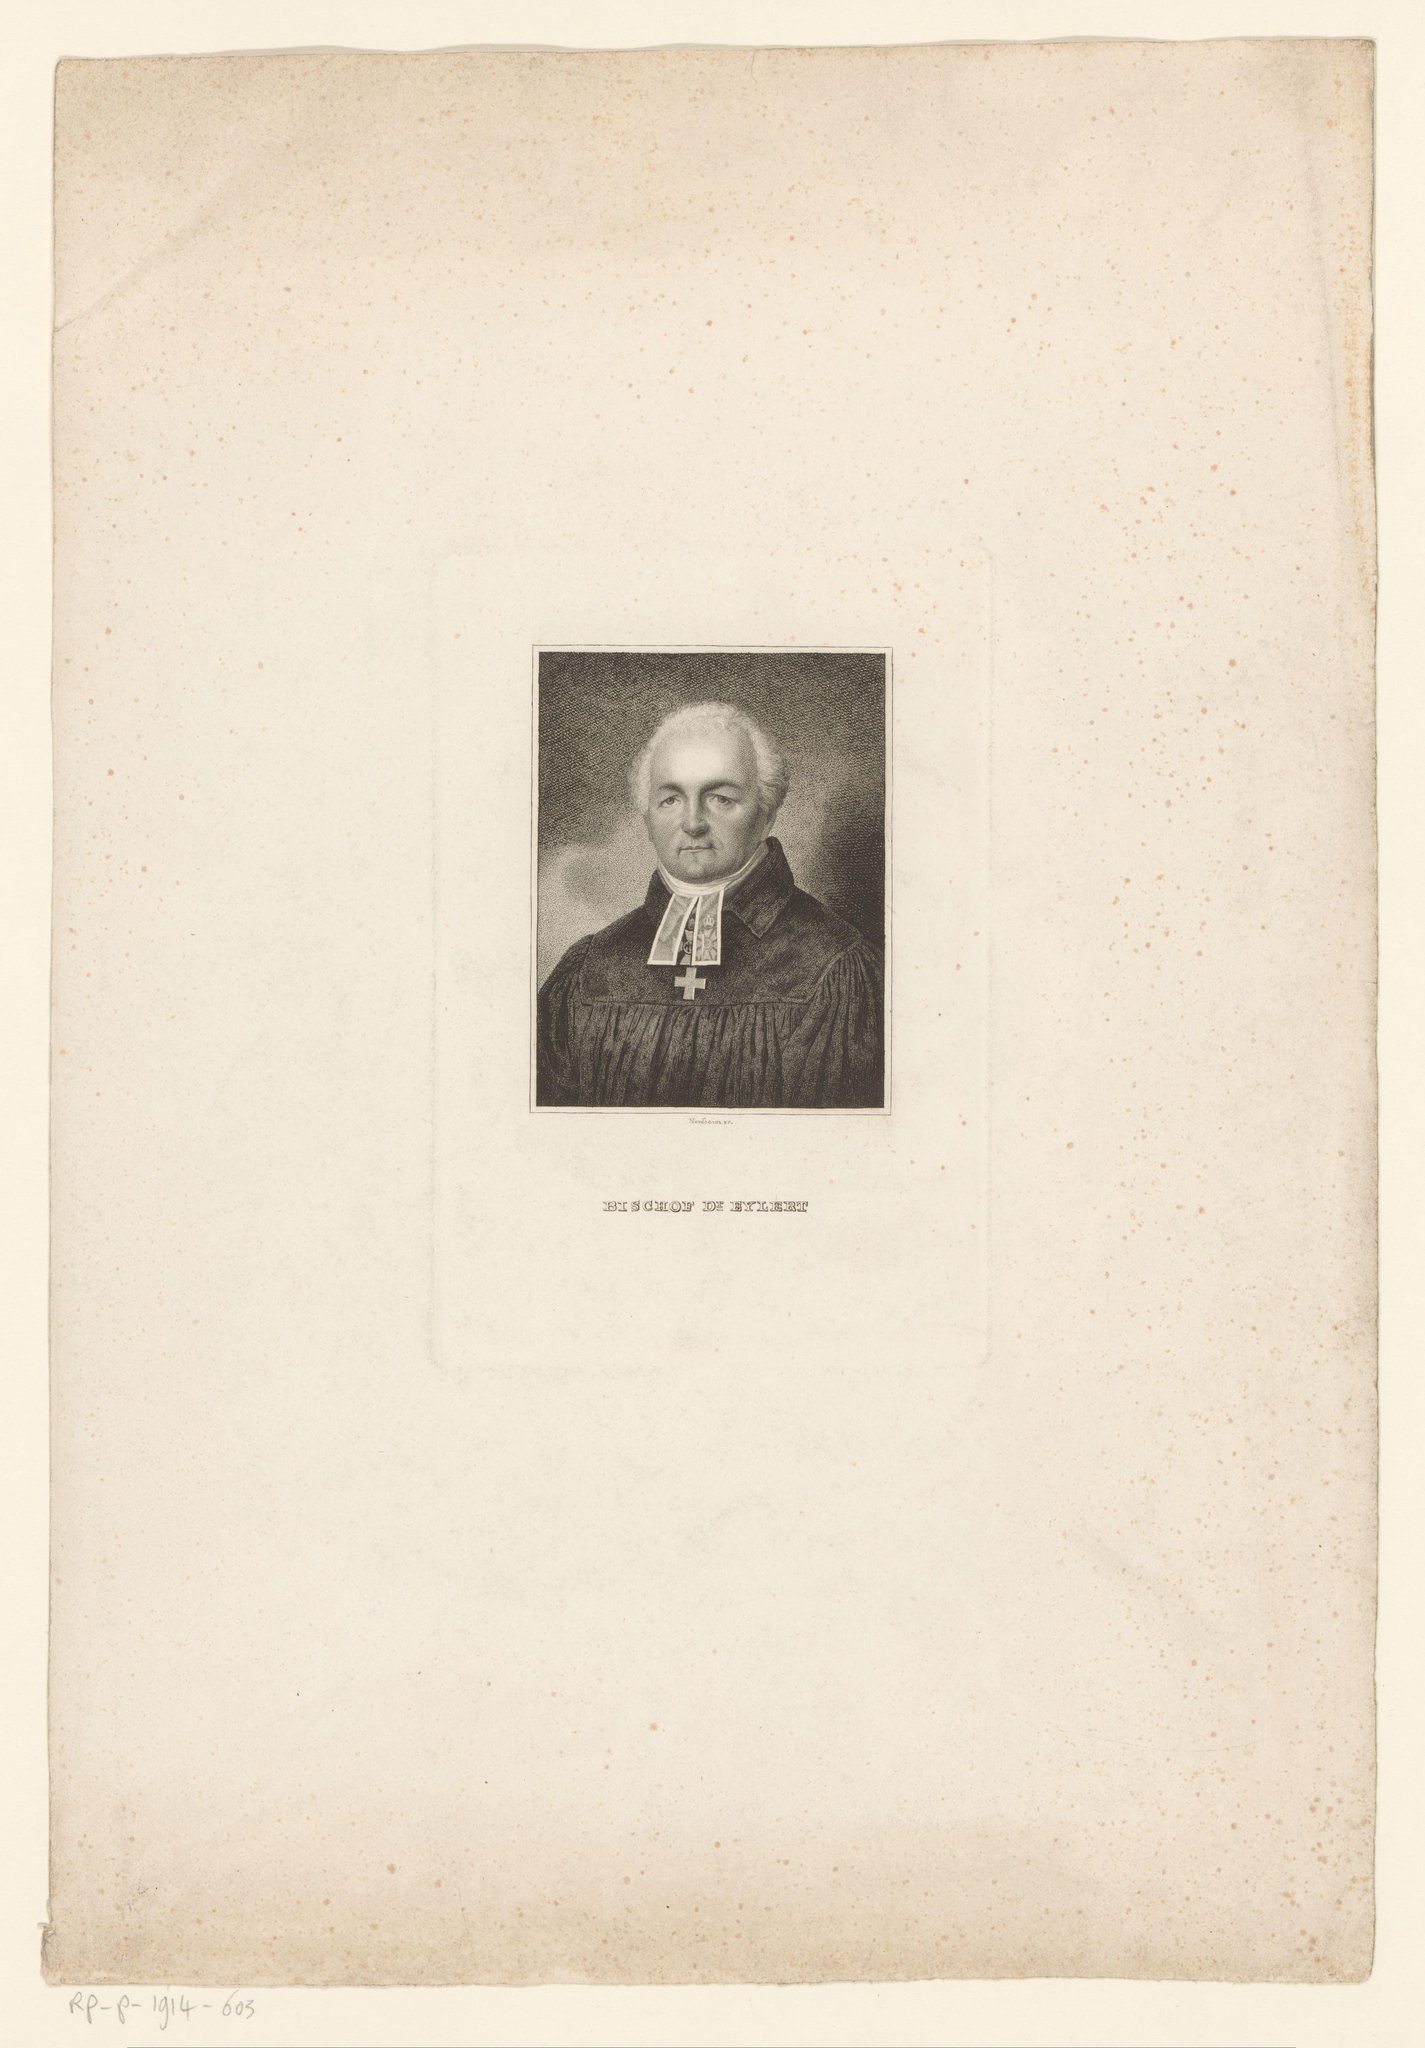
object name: print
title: Portret van Rulemann Friedrich Eylert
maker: johann georg nordheim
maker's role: print maker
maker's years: 1804-1853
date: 1814-1829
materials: paper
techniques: engraving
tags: historical persons, medals and other marks of military honour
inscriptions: collector's mark: Lugt 2228